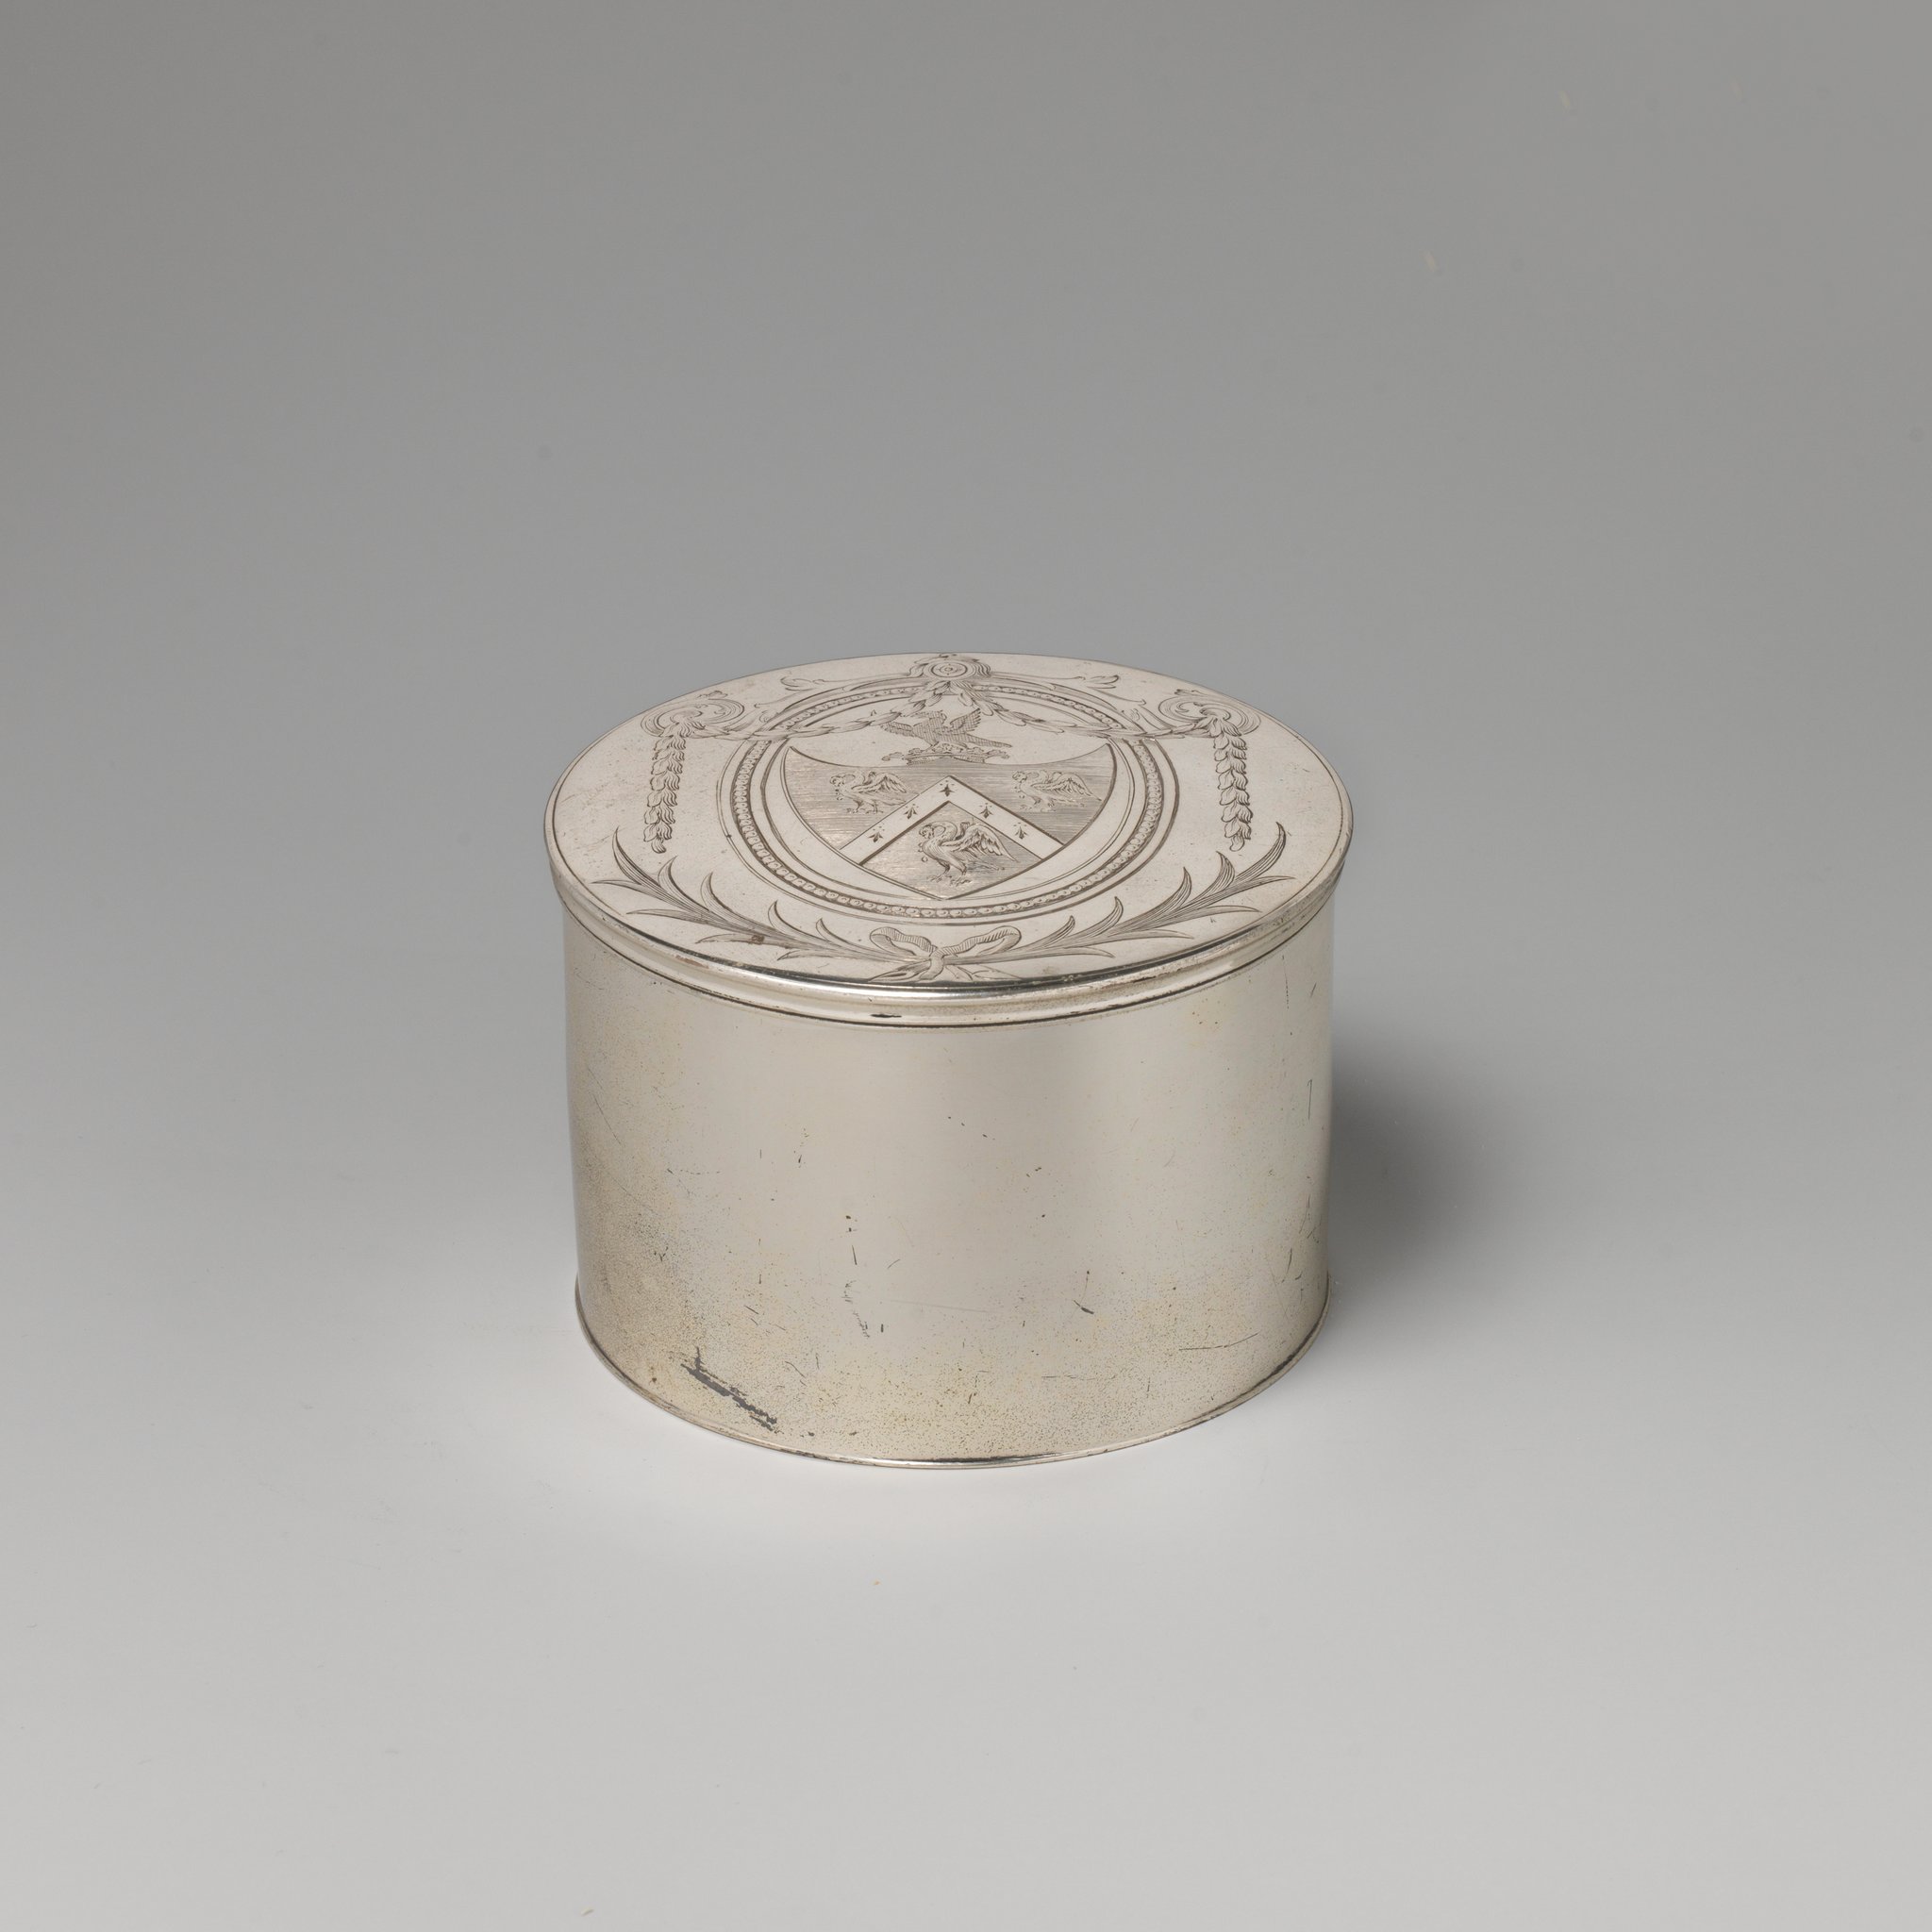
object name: box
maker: magdalen feline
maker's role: maker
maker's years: 1753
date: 1771-1772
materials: silver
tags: coat of arms